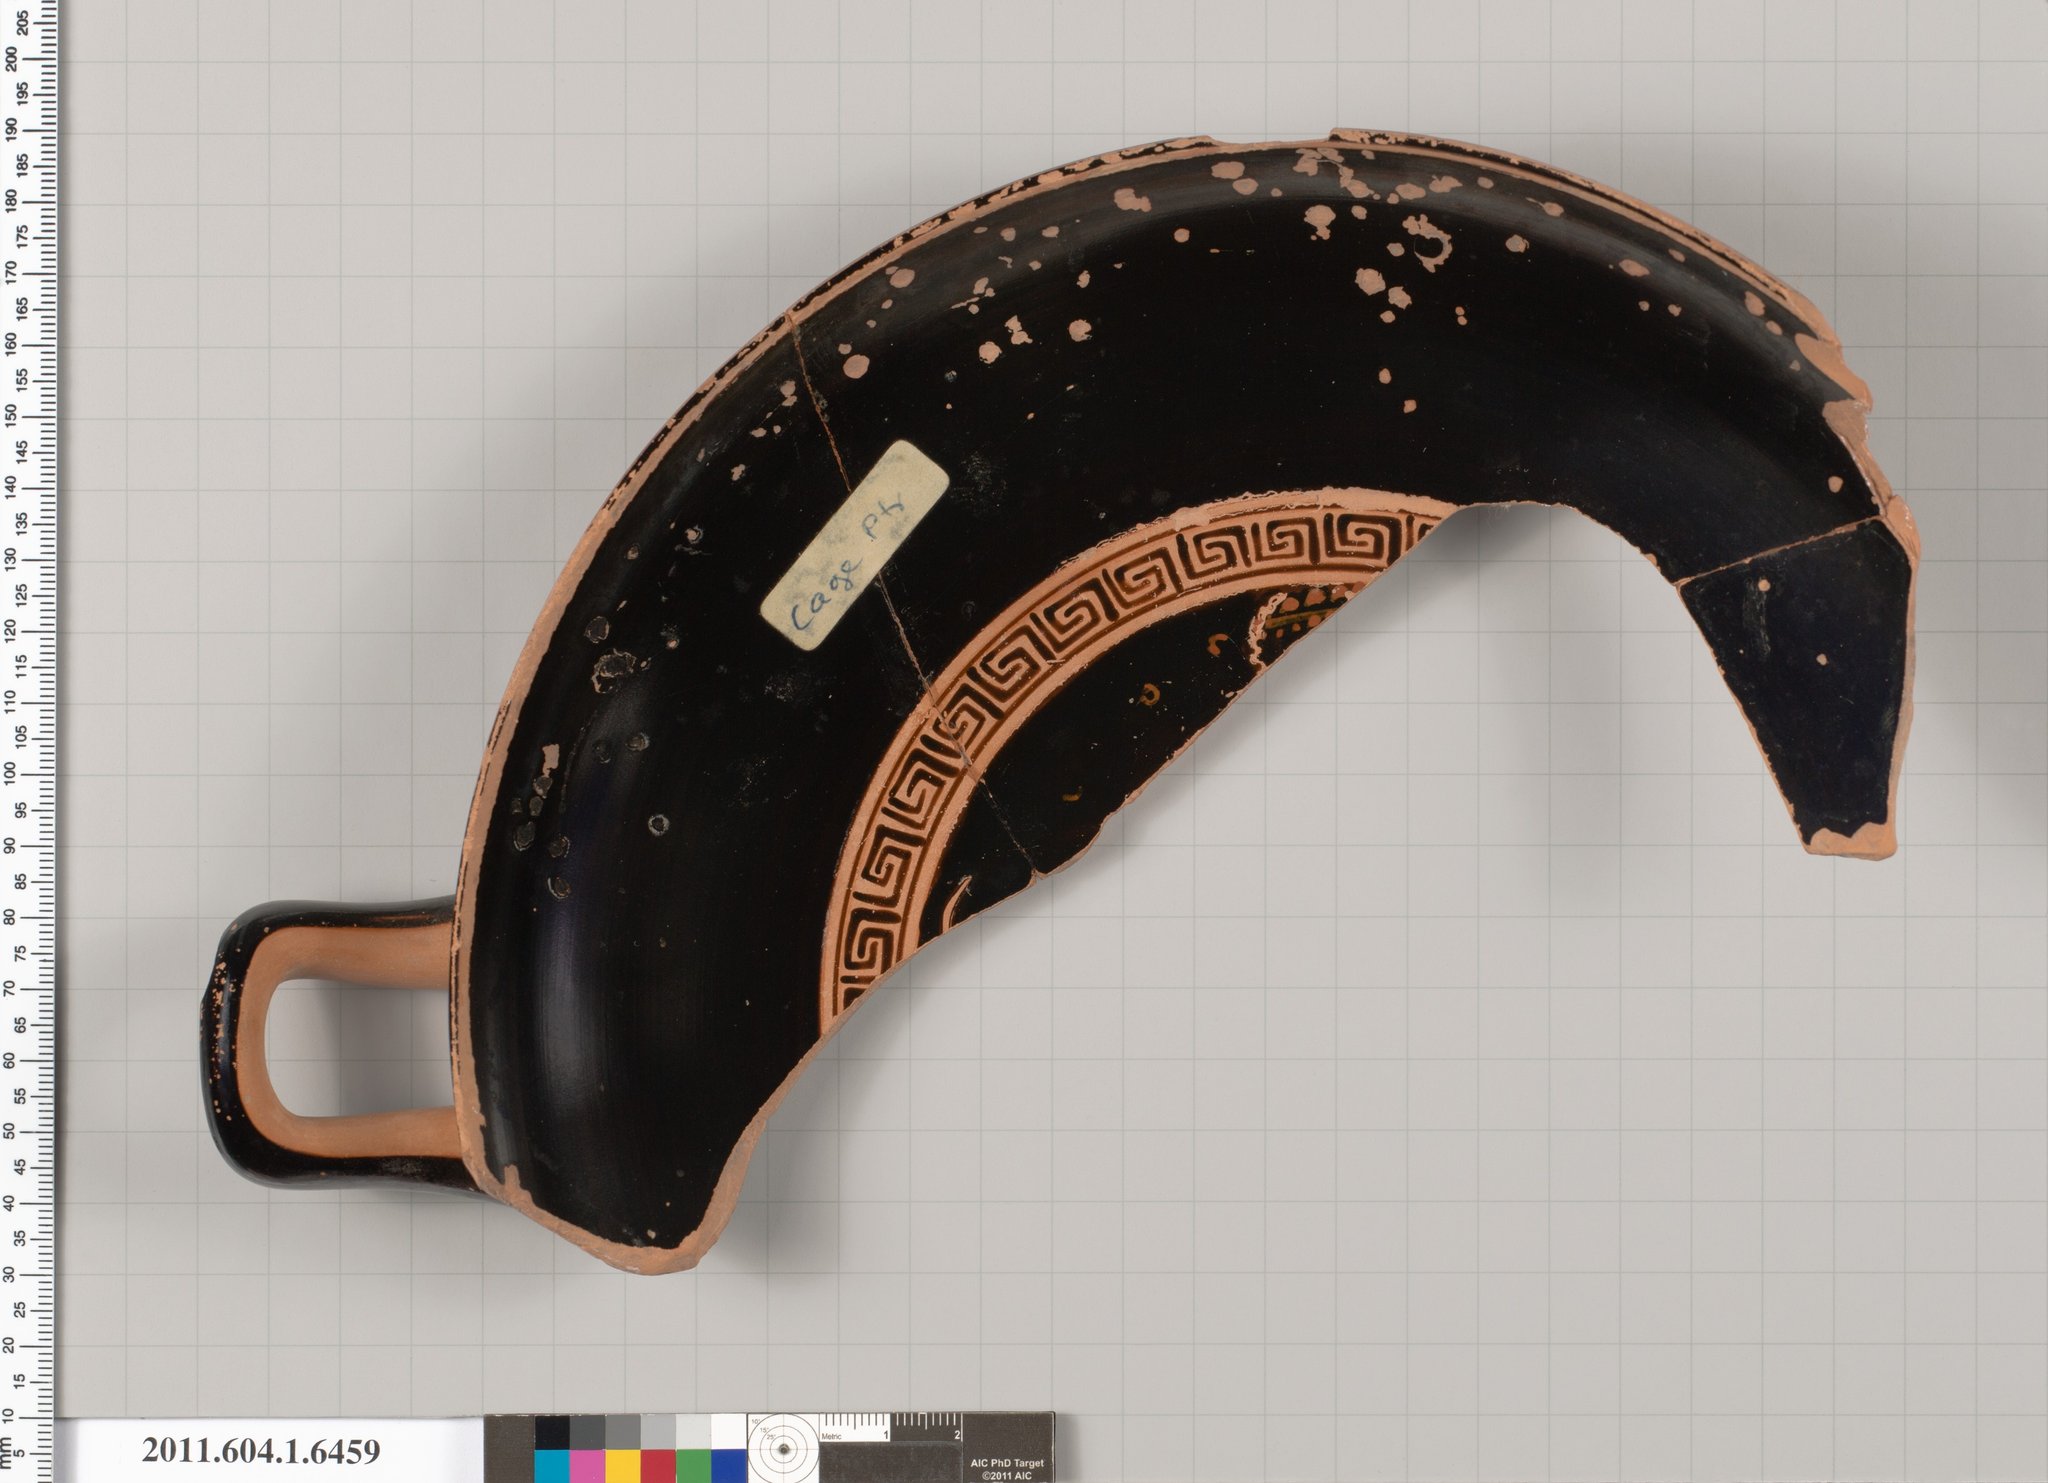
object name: kylix fragment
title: Terracotta fragment of a kylix (drinking cup)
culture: greek, attic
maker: cage painter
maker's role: artist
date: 490-480 BCE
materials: terracotta